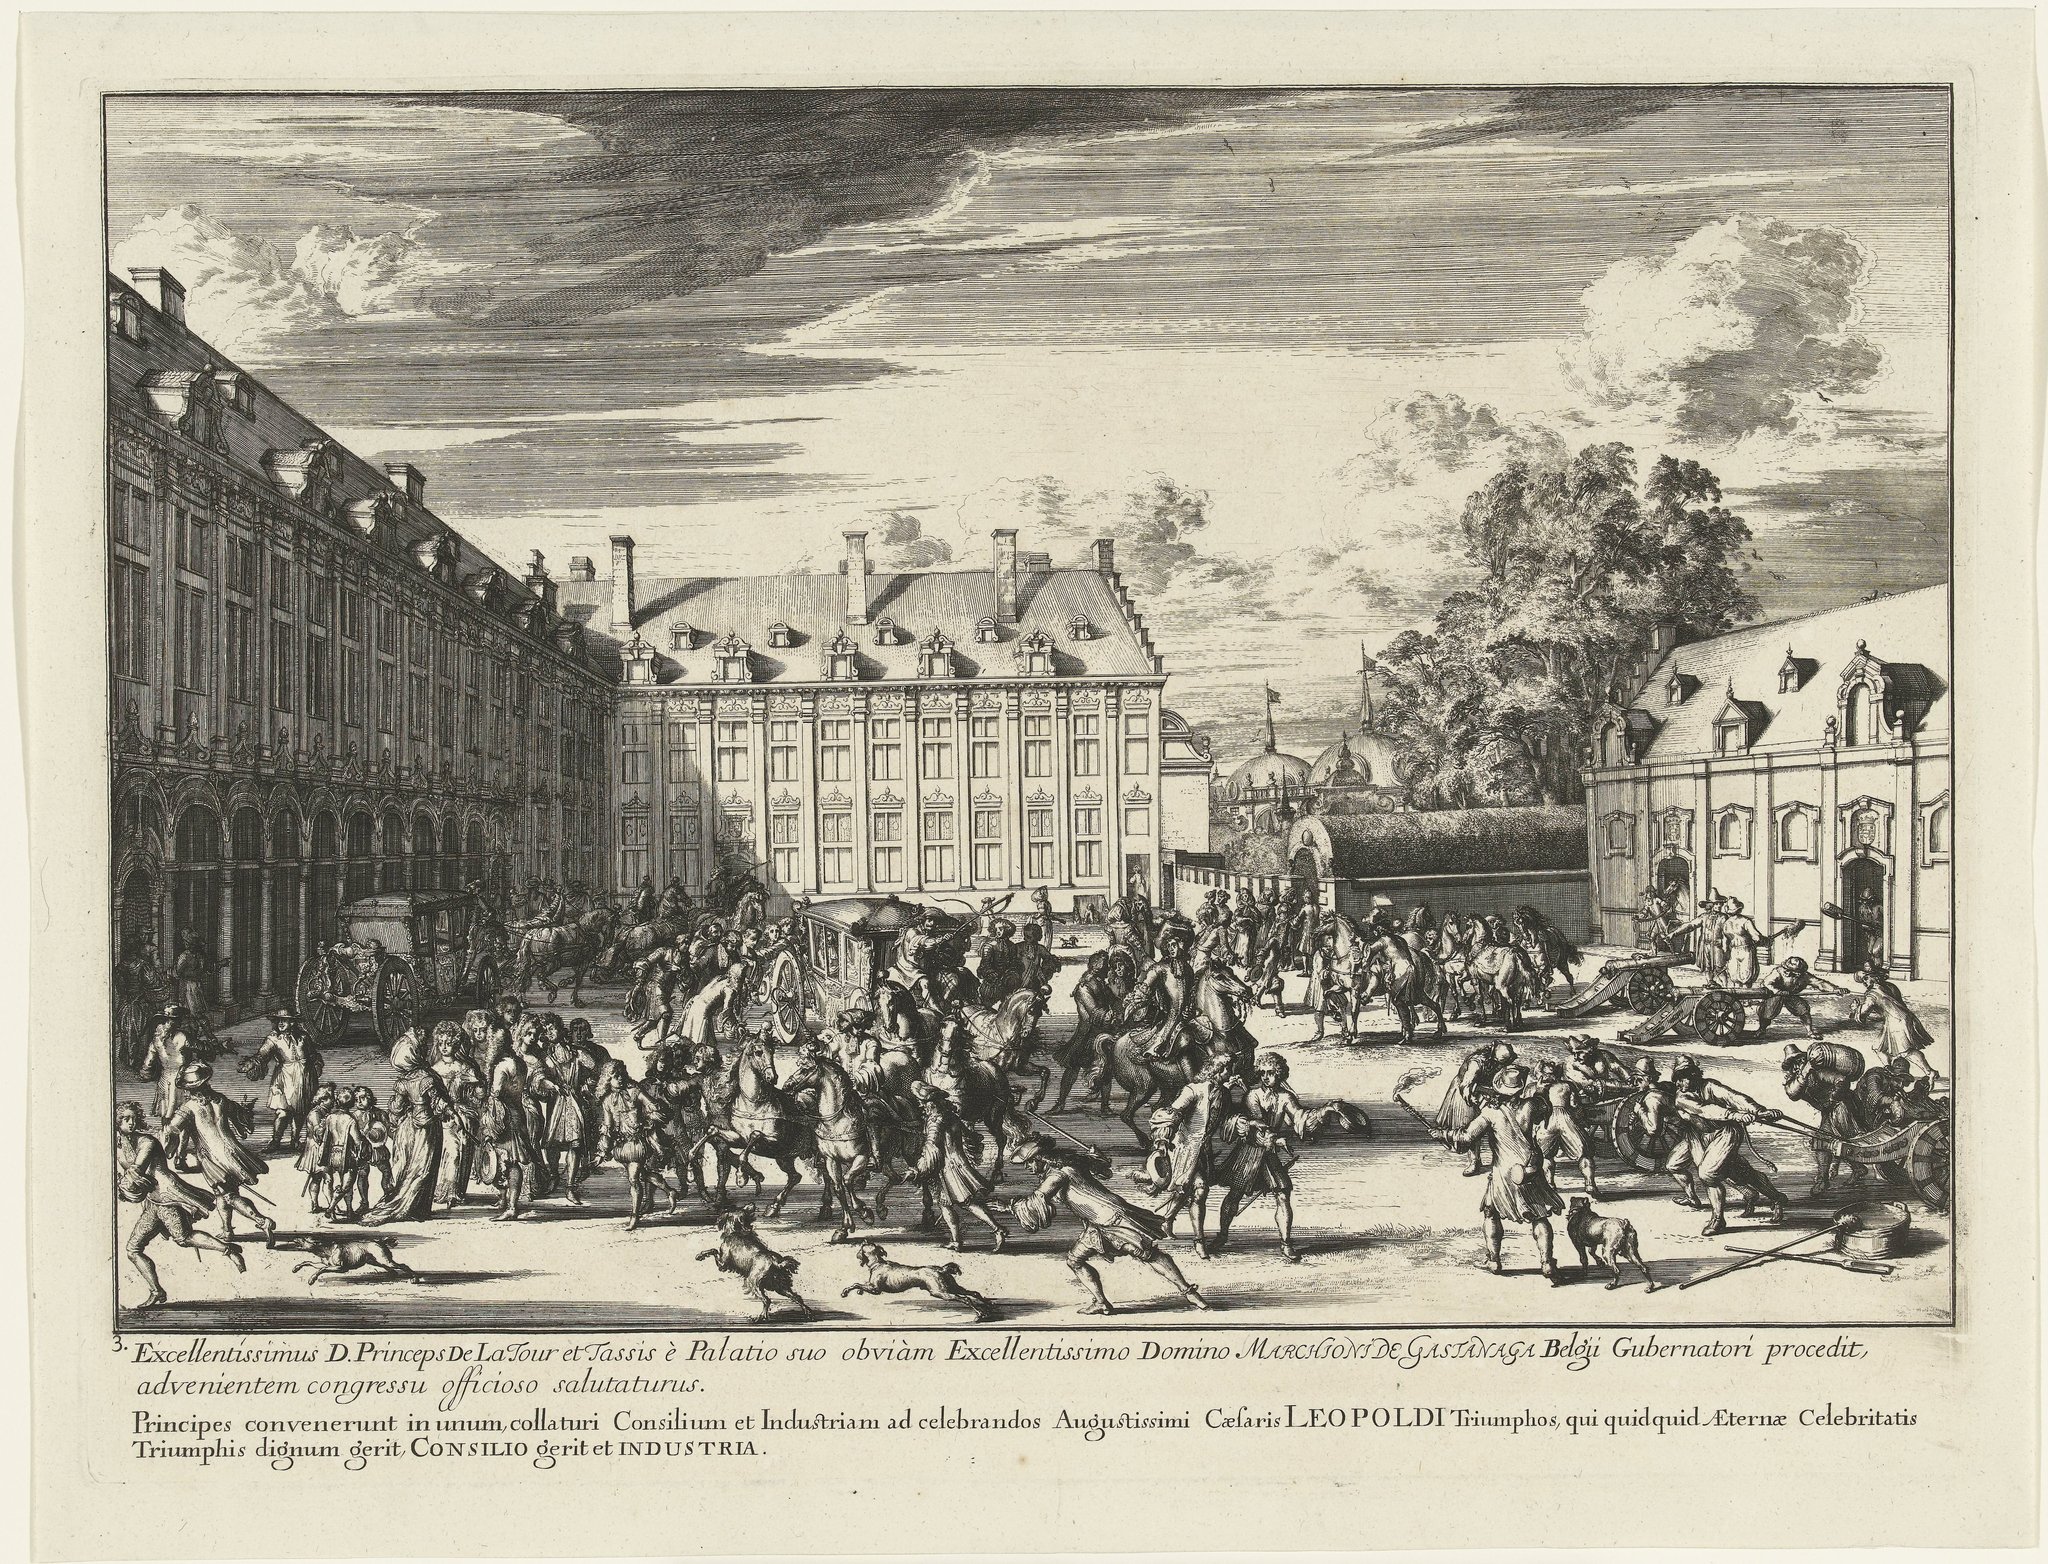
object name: print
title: Intocht van Leopold I in Brussel na het verslaan van de Turken, 1686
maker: romeyn de hooghe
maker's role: draughtsman, goldsmith, painter, print maker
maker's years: 1645-1708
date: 1686-1687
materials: paper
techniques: etching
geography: haarlem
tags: francisco antonio de agurto (markies van gastañaga), vienna, leopold i (keizer van duitsland), triumphal entry and public reception, pageant, 'entrée solennelle', 'joyeuse entrée', cannon shots (military salute), brussels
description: Intocht van Leopold I in Brussel, 1686. Twee koetsen komen aangereden bij het Hof van Thurn en Tassis. Rechts worden kanonnen klaargemaakt om saluutschoten te geven.